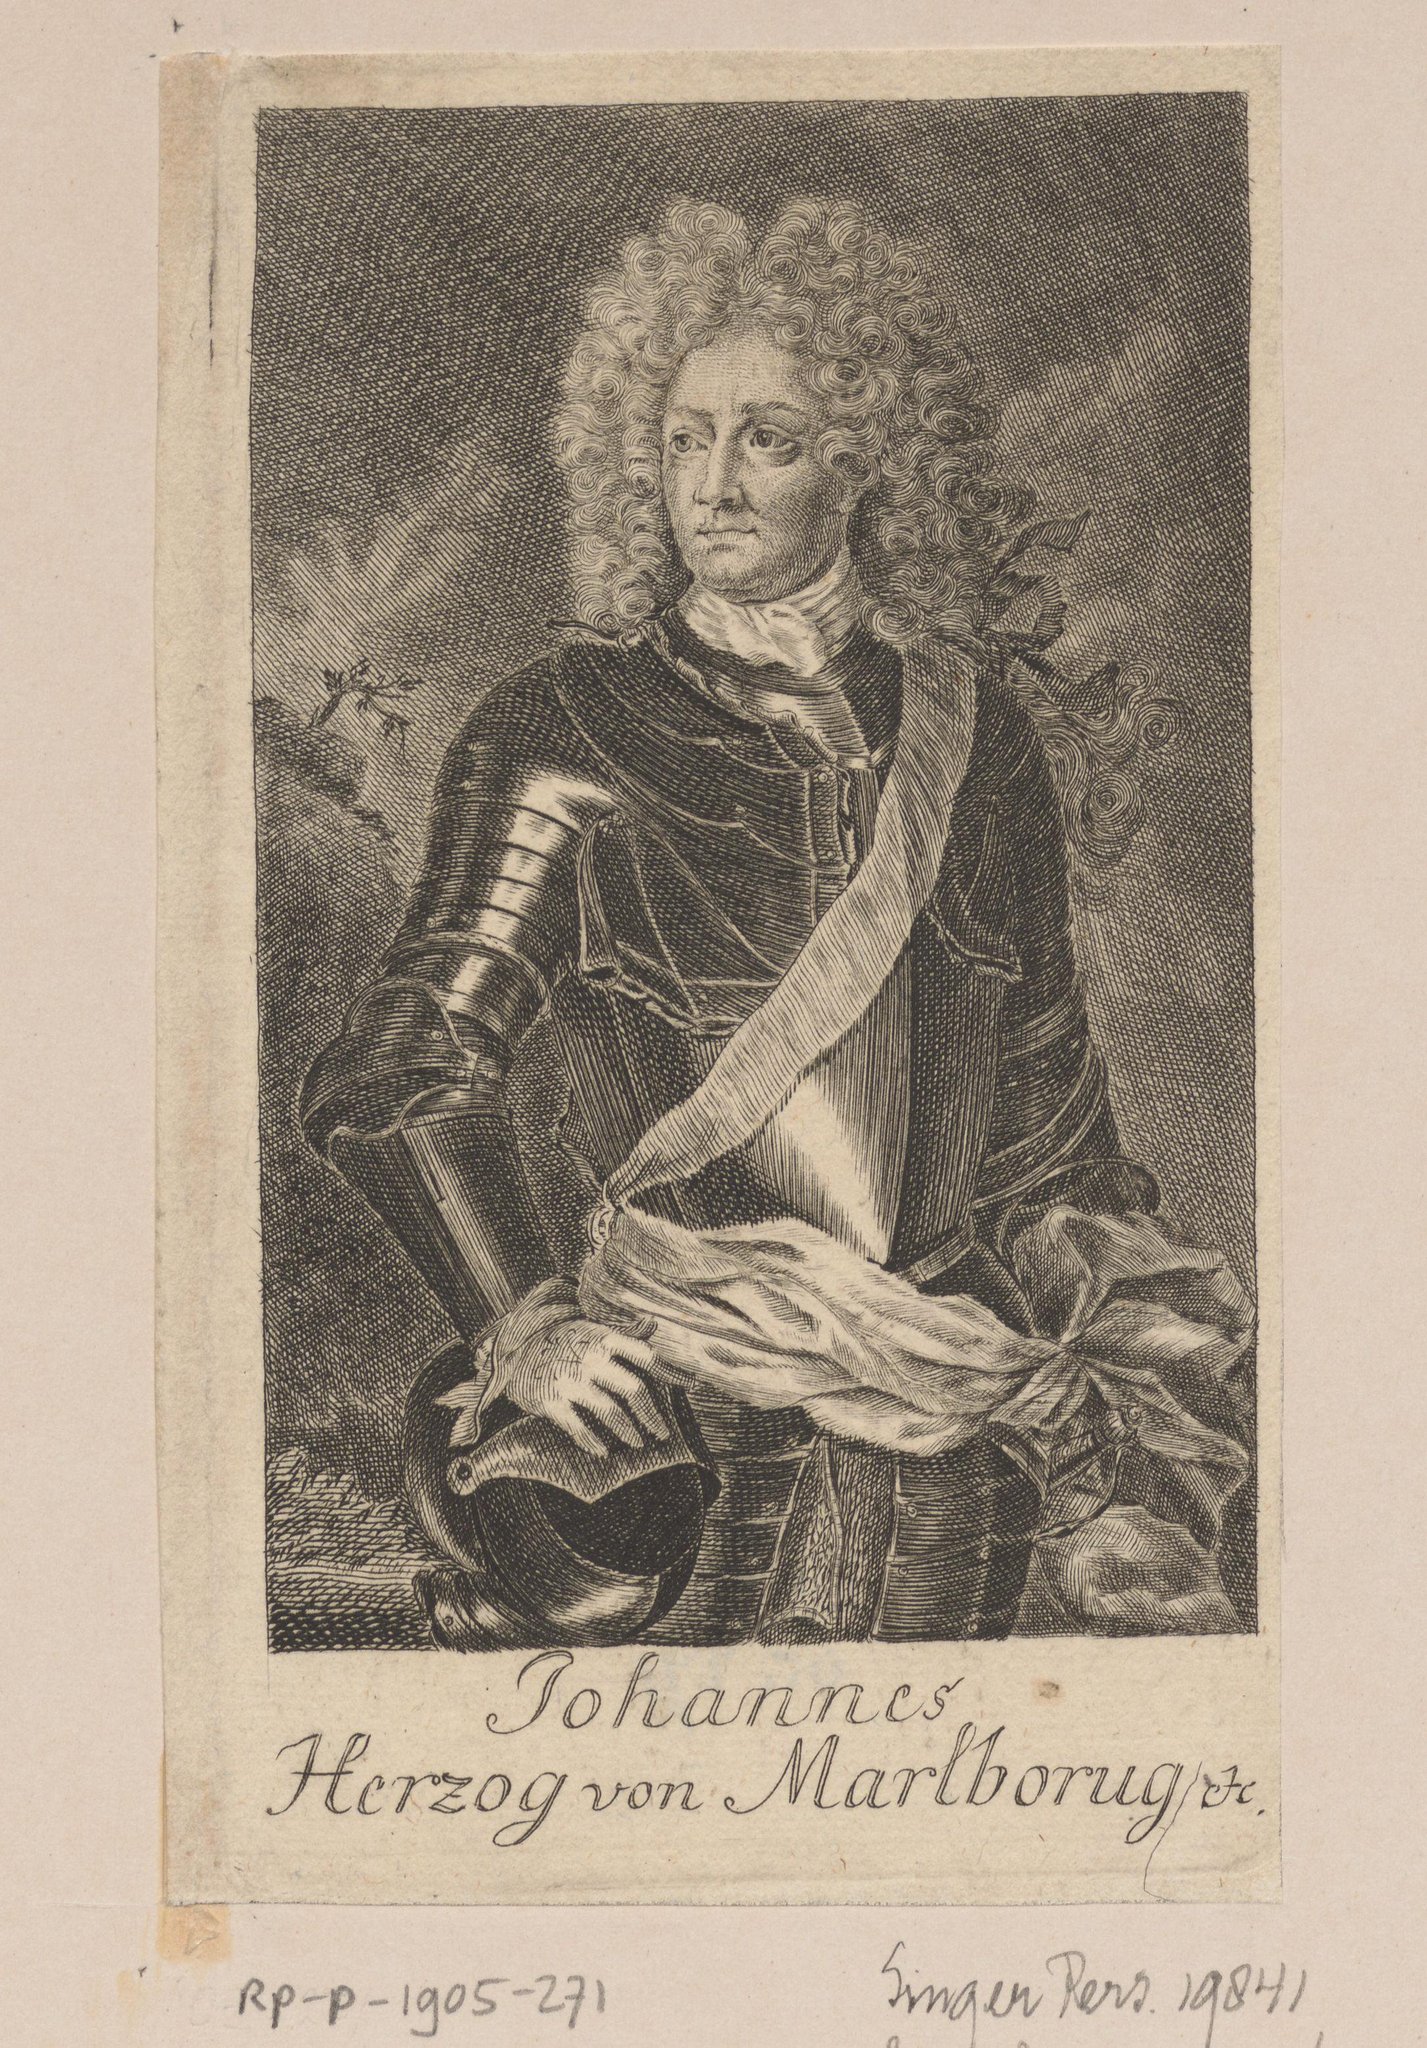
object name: print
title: Portret van John Churchill, hertog van Marlborough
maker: martin bernigeroth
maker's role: print maker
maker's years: 1670-1733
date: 1710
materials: paper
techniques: engraving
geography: germany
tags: john churchill (1e hertog van marlborough), armour, historical persons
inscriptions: collector's mark: Lugt 2228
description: Prent waarschijnlijk uit: Neu-eröffneter Welt- und Staatsspiegel, vol. 13, 1710. Of uit: Bonneval, Claude Alexandre de. Merckwürdiges Leben des Grafen von Bonneval (...). S.l.s.n., 1738.